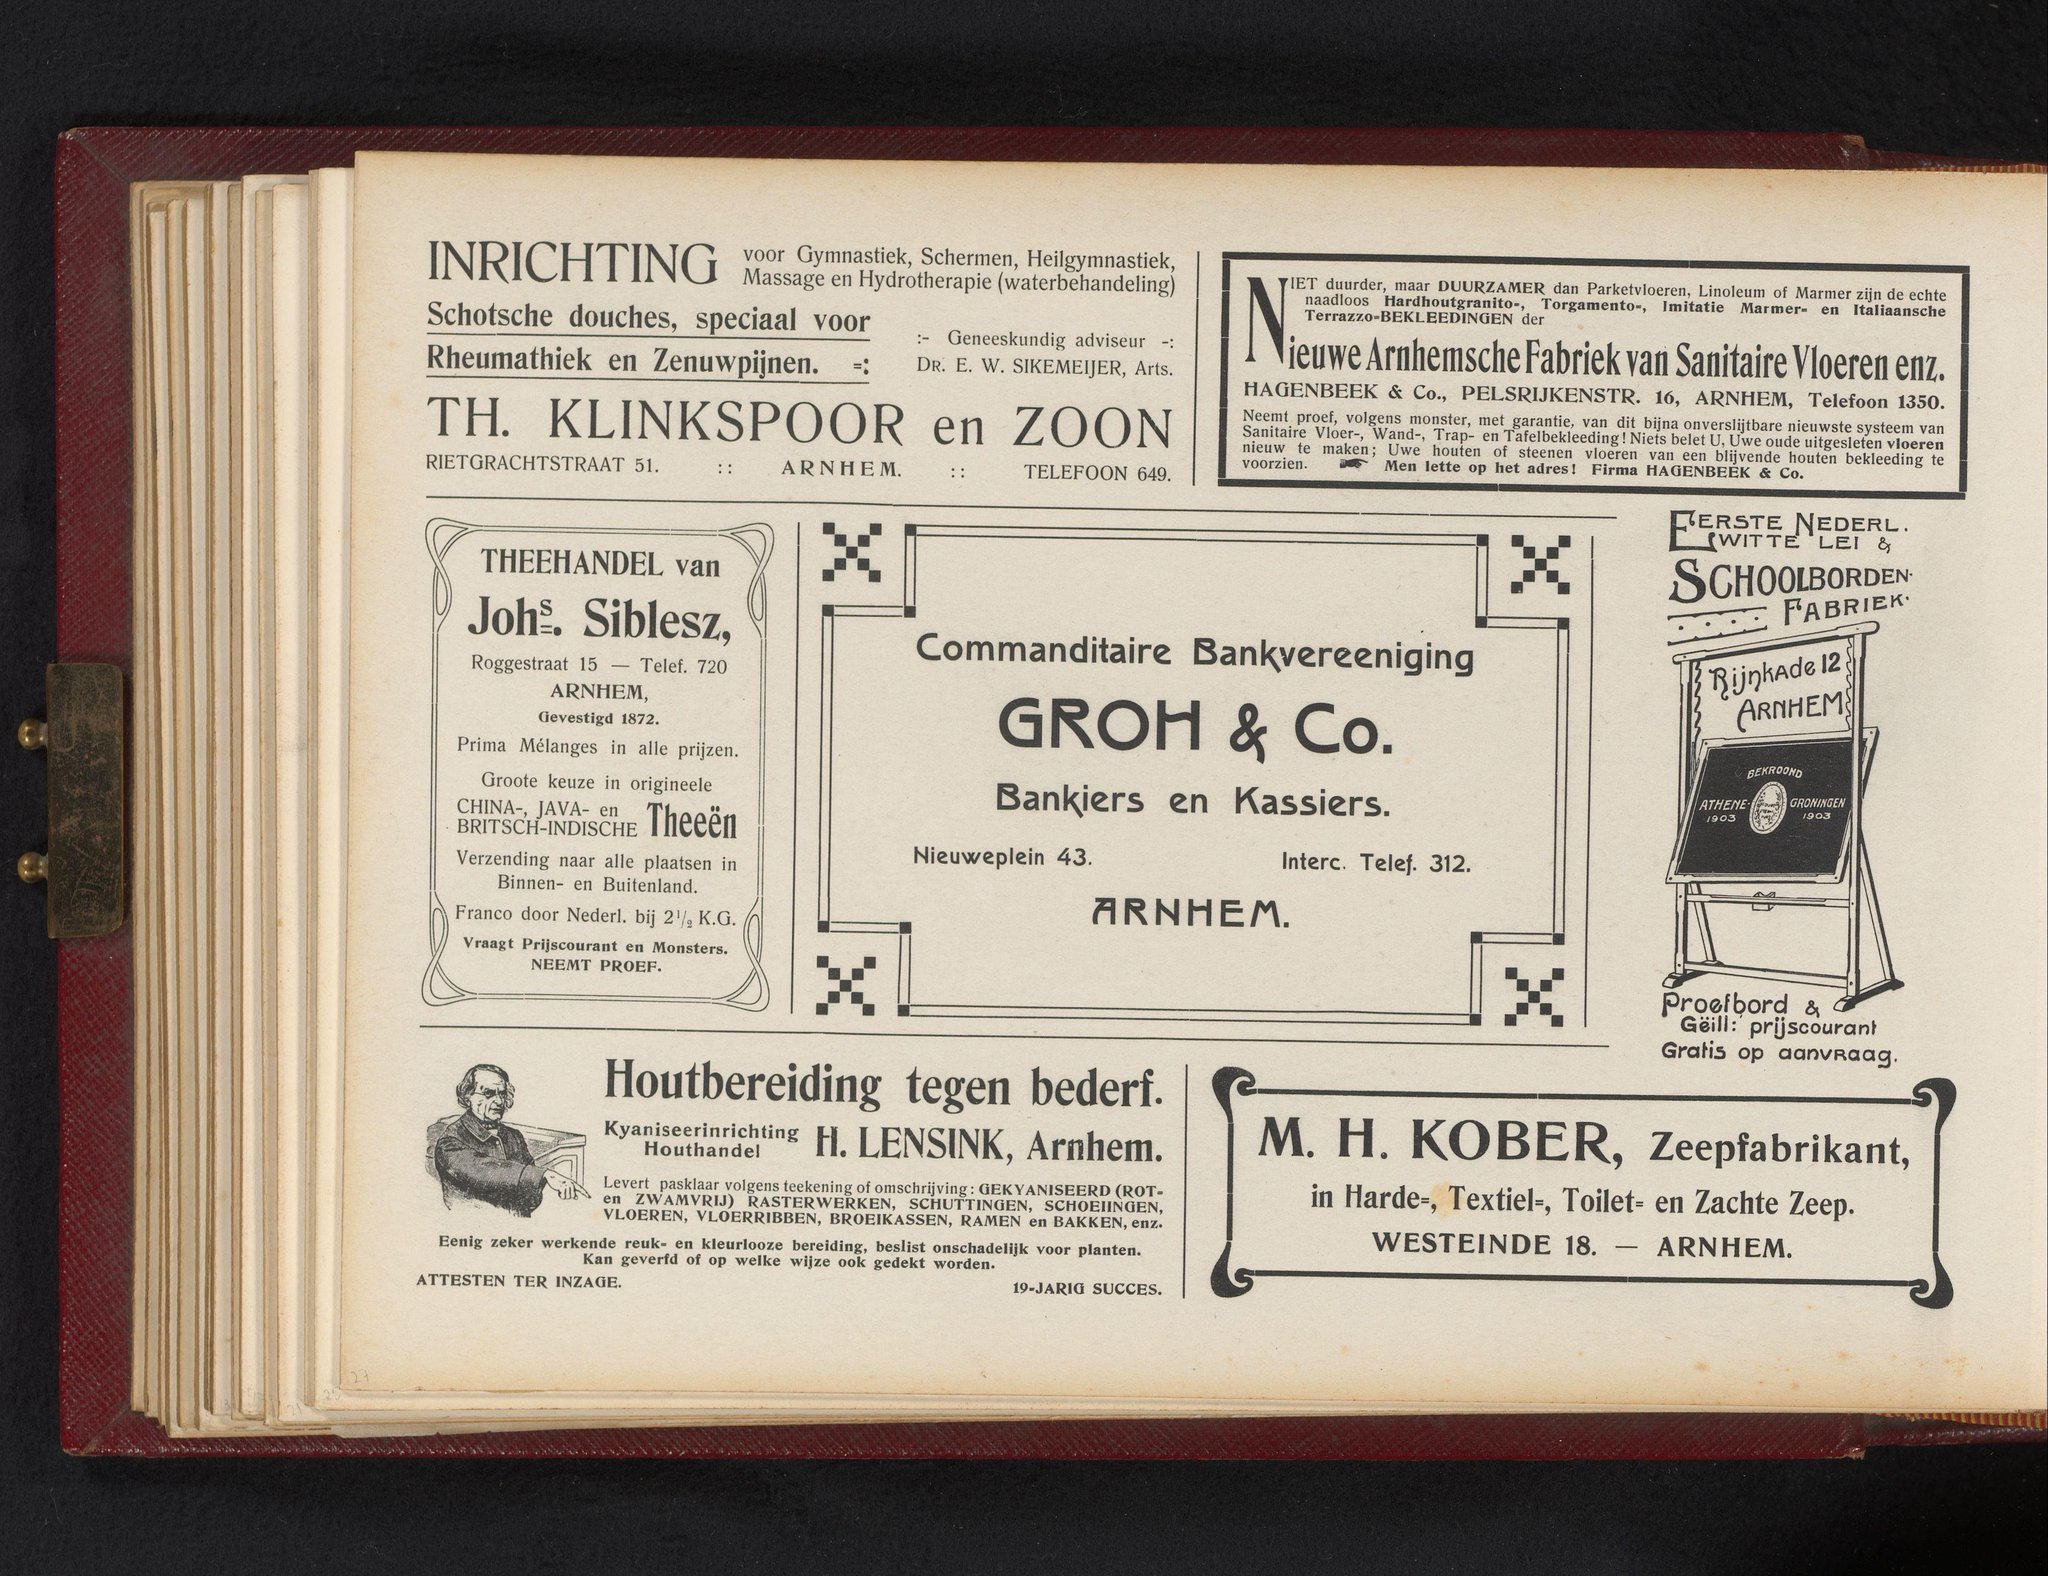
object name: album leaf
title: Advertenties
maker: Anonymous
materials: paper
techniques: printing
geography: netherlands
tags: advertising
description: Advertenties voor onder andere Th. Klinkspoor en Zoon, Nieuwe Arnhemsche Fabriek van Sanitaire vloeren enz. Hagenbeek & Co., Theehandel van Johs. Siblesz, Commanditaire bankvereeniging Groh & Co., Eerste Nederl. witte lei & schoolbordenfabriek, Kyaniseerinrichting & houthande H. Lensink en Zeepfabrikant M. H. Kober. Deze pagina maakt deel uit van een album.